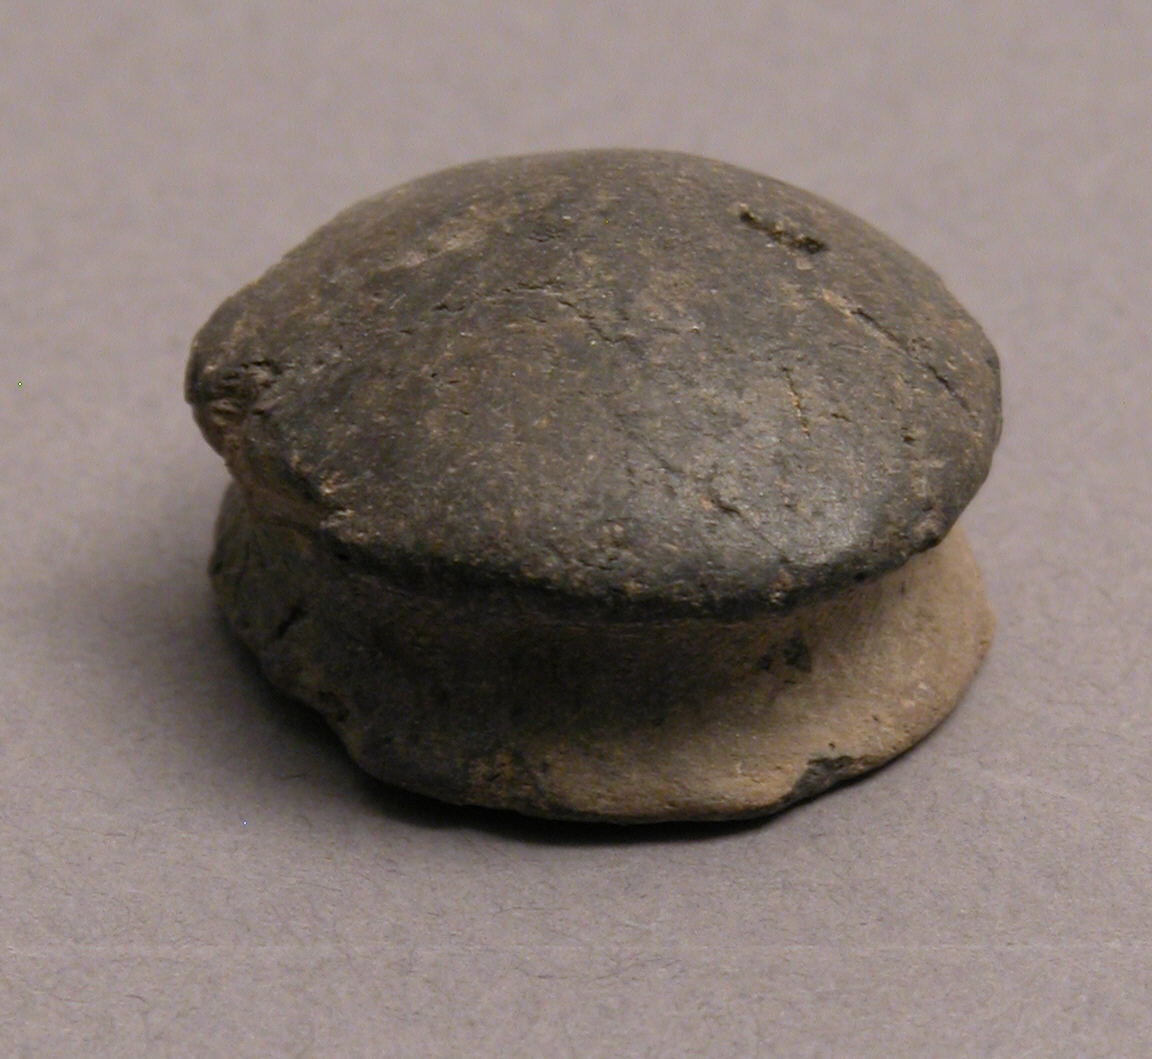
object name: game piece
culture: coptic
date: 301-700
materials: earthenware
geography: egypt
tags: games